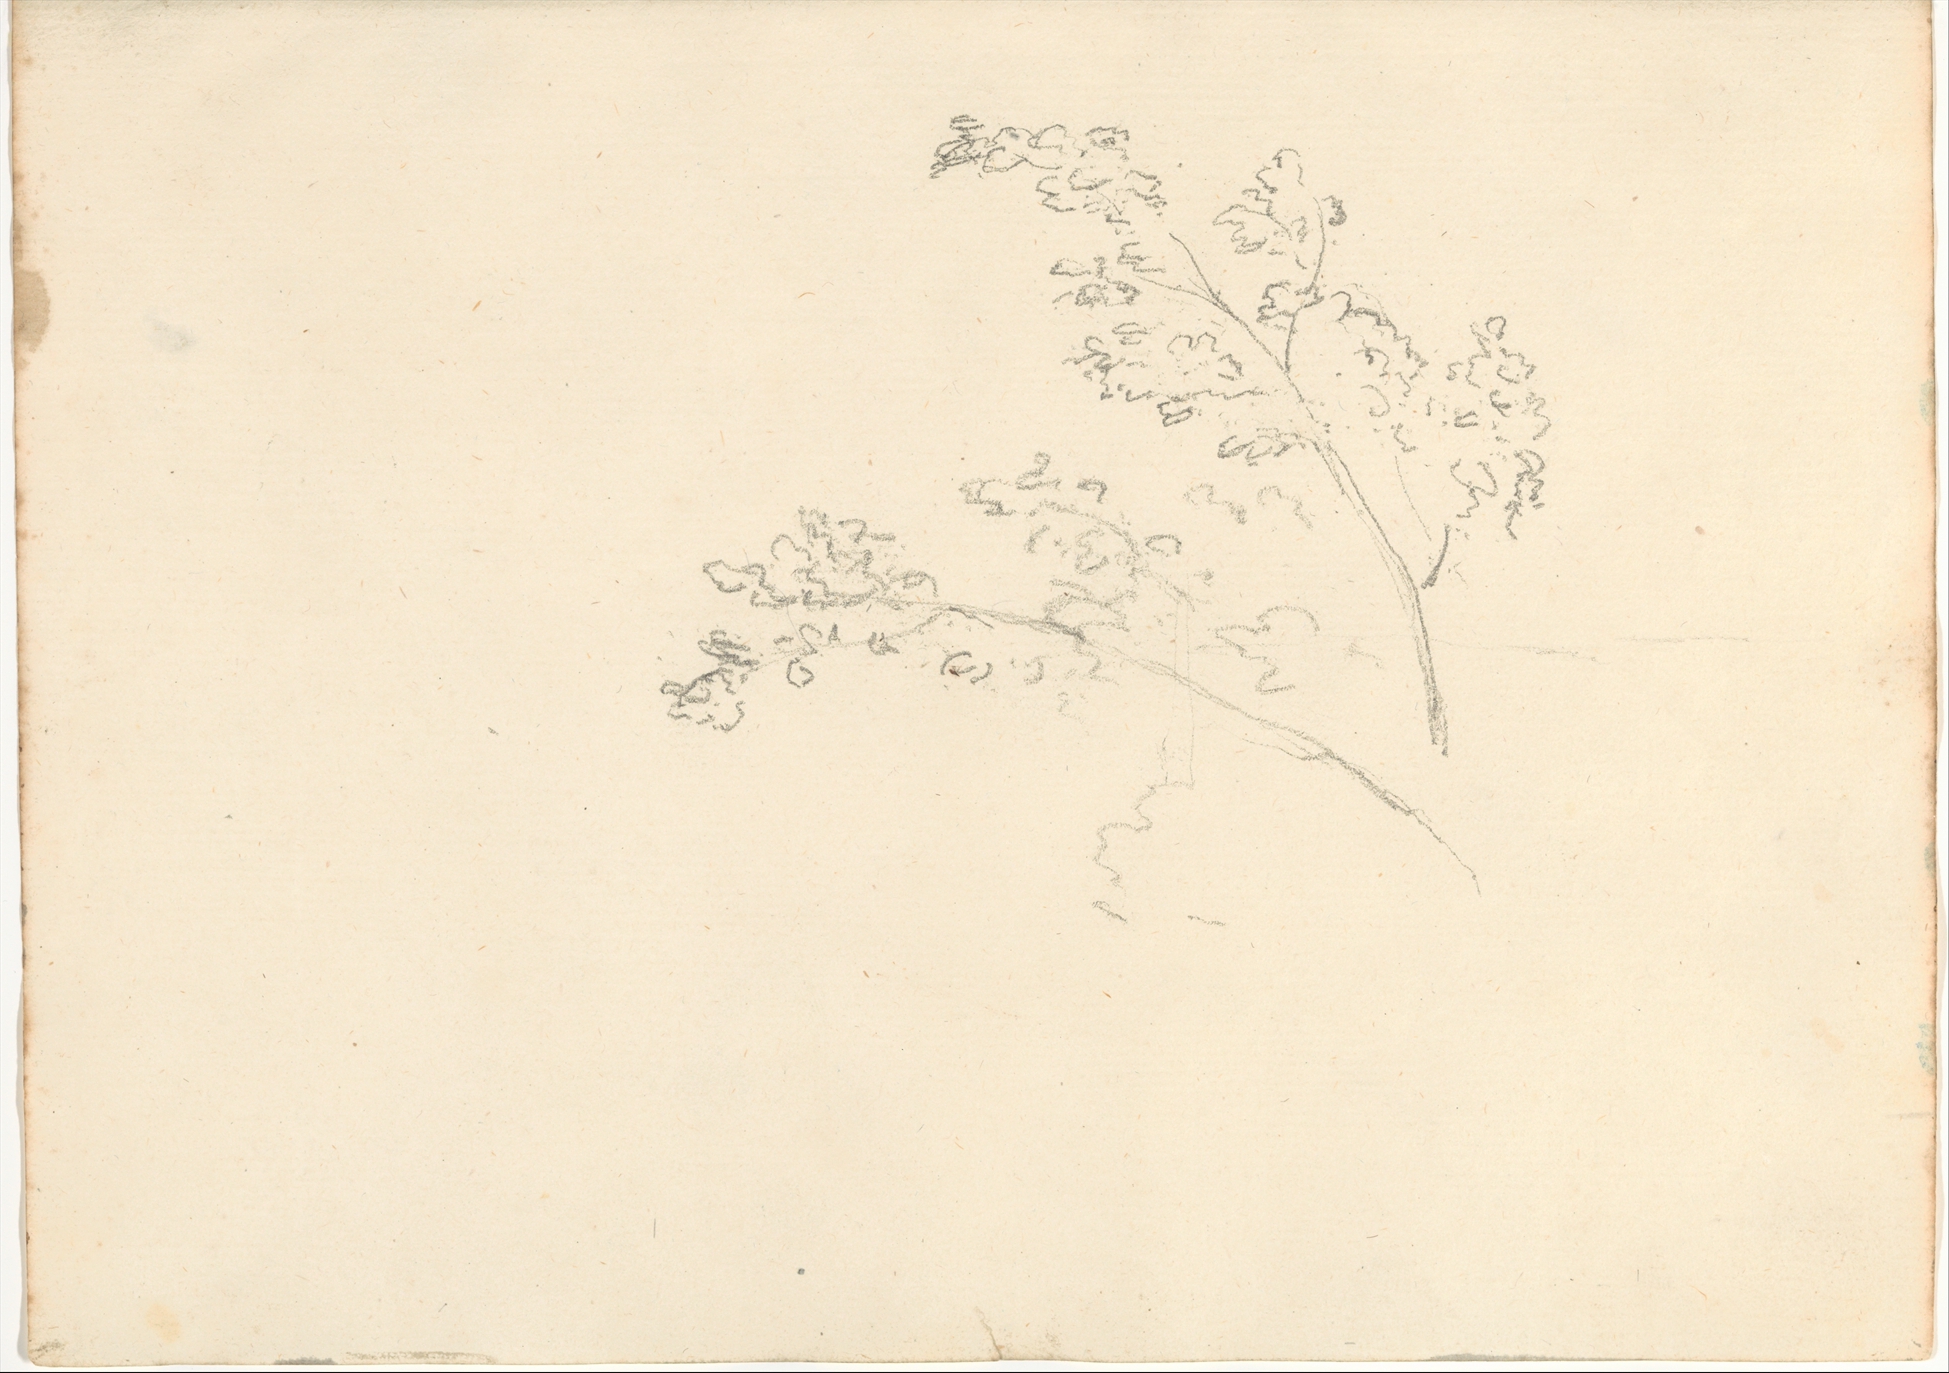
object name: drawing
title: Tree branches (Smaller Italian sketchbook, leaf 30 recto)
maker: joseph wright (wright of derby)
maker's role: artist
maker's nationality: british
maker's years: 1734-1797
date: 1774-1775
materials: graphite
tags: leaves,trees